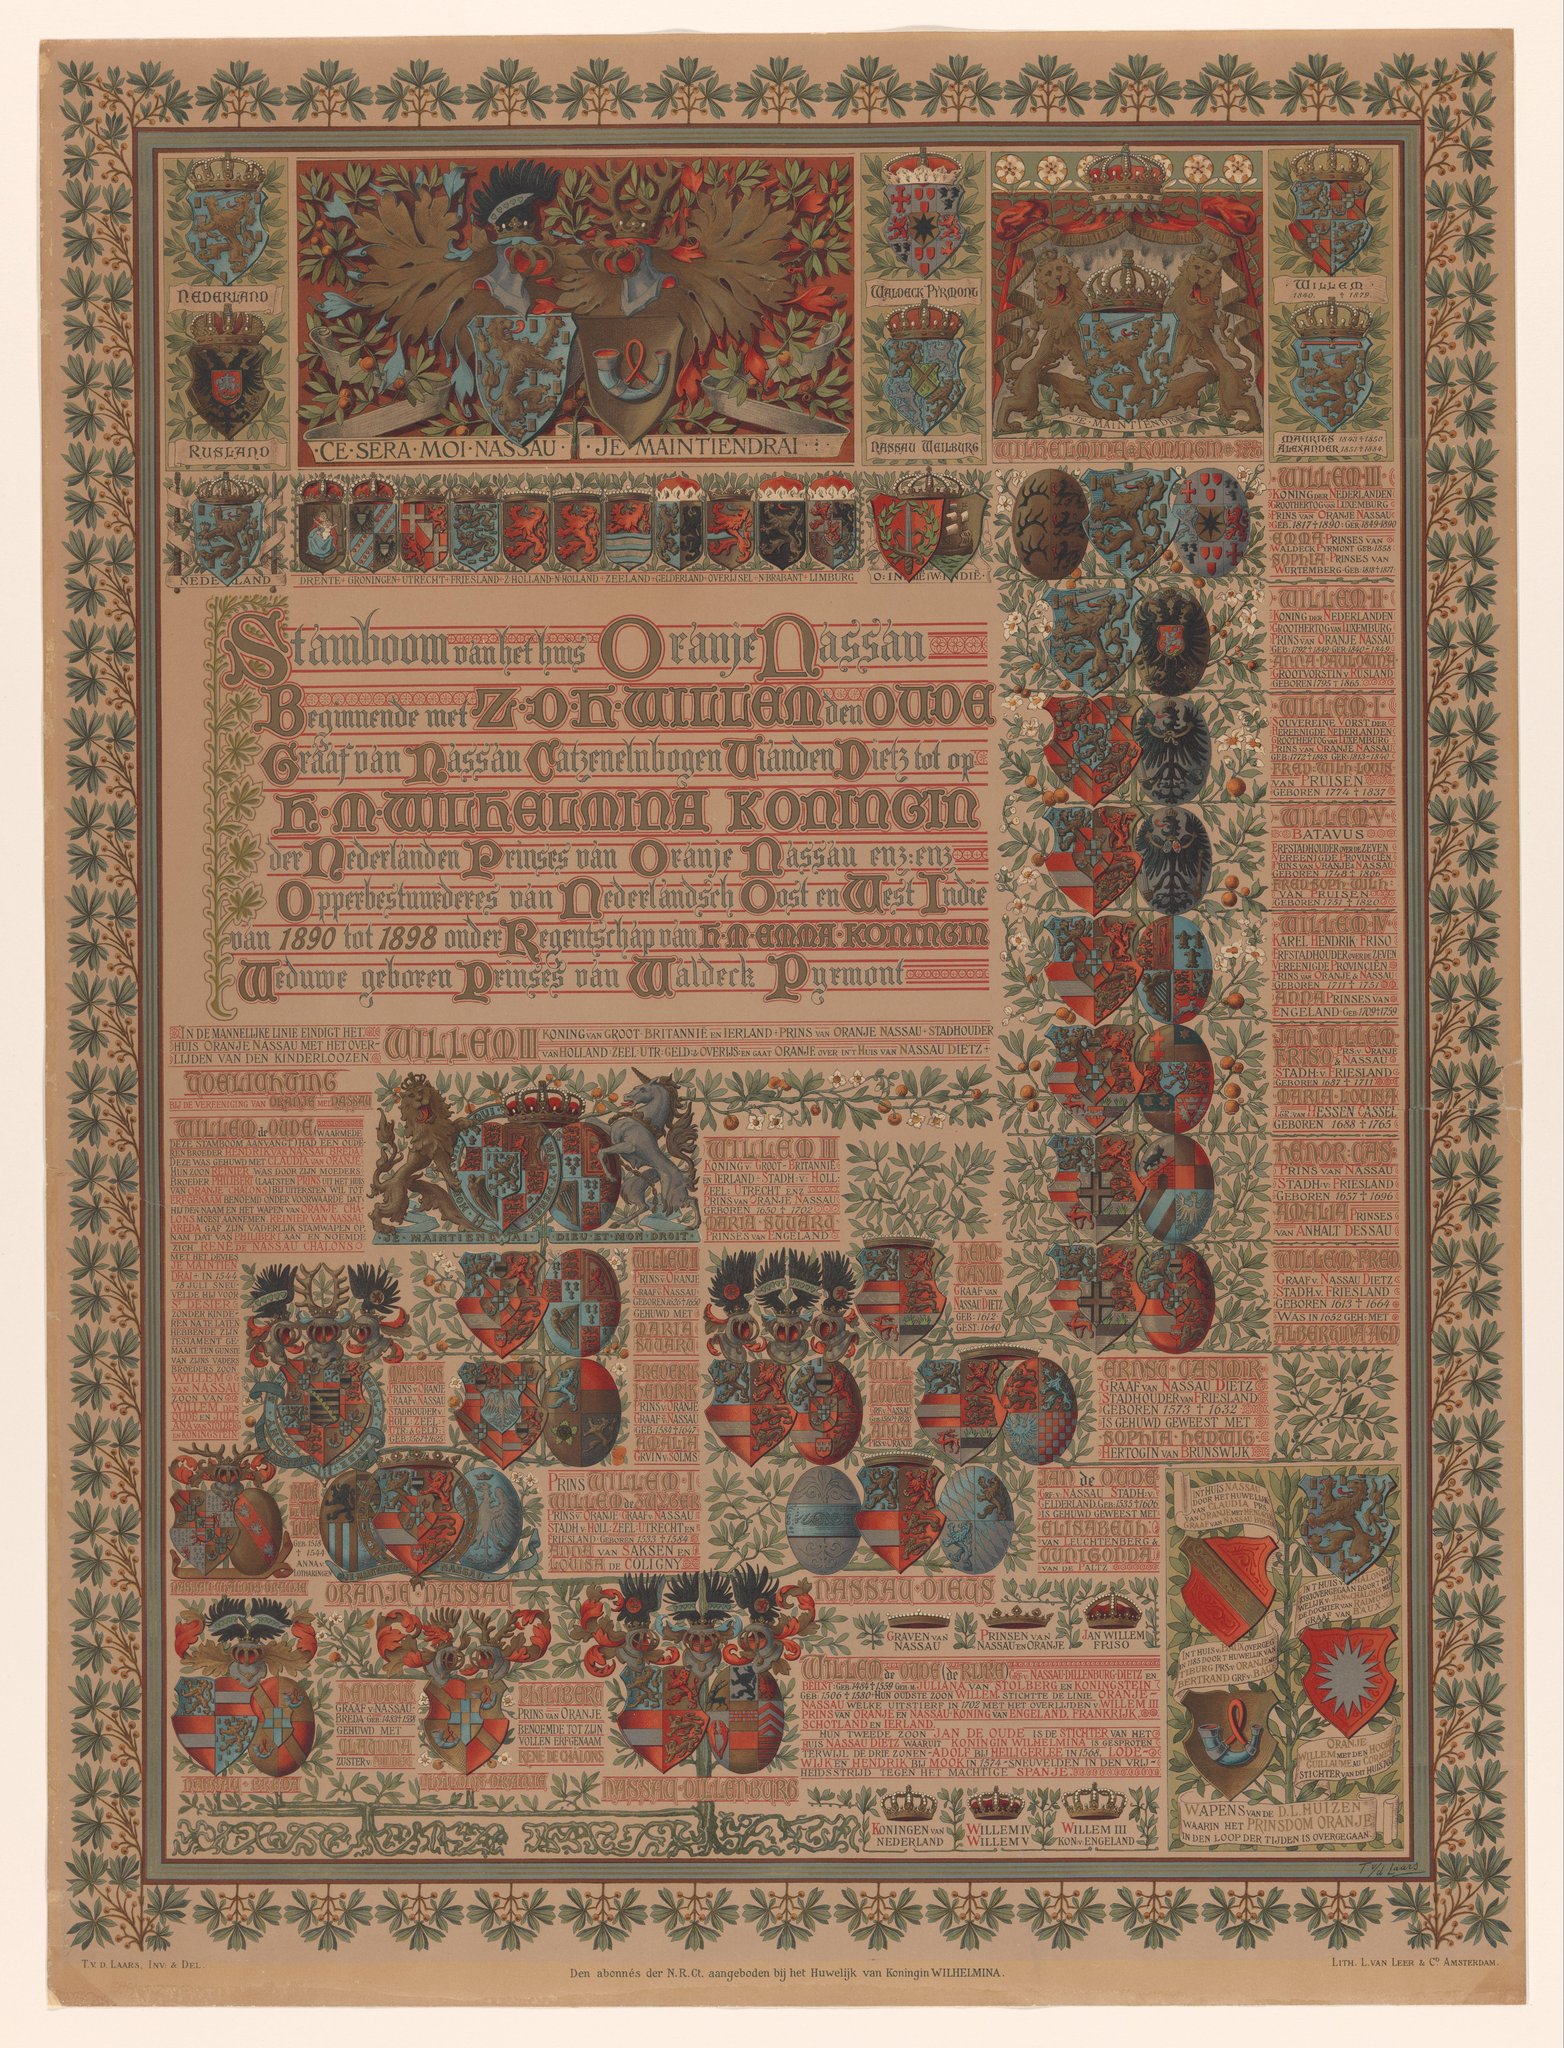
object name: print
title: Stamboom van het huis Oranje Nassau Beginnende met Z.D.H. Willem den Oud (...)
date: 1901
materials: paper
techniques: lithograph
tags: family lineage, pedigree, genealogical tree or table, armorial bearing, heraldry, series of rulers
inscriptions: annotation: ‘Den abonnés der N.R.Ct aangeboden bij het Huwelijk van Koningin Wilhelmina.’, collector's mark: Lugt 2228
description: Namen en wapens, waartussen en waaromheen oranjeboompjes.